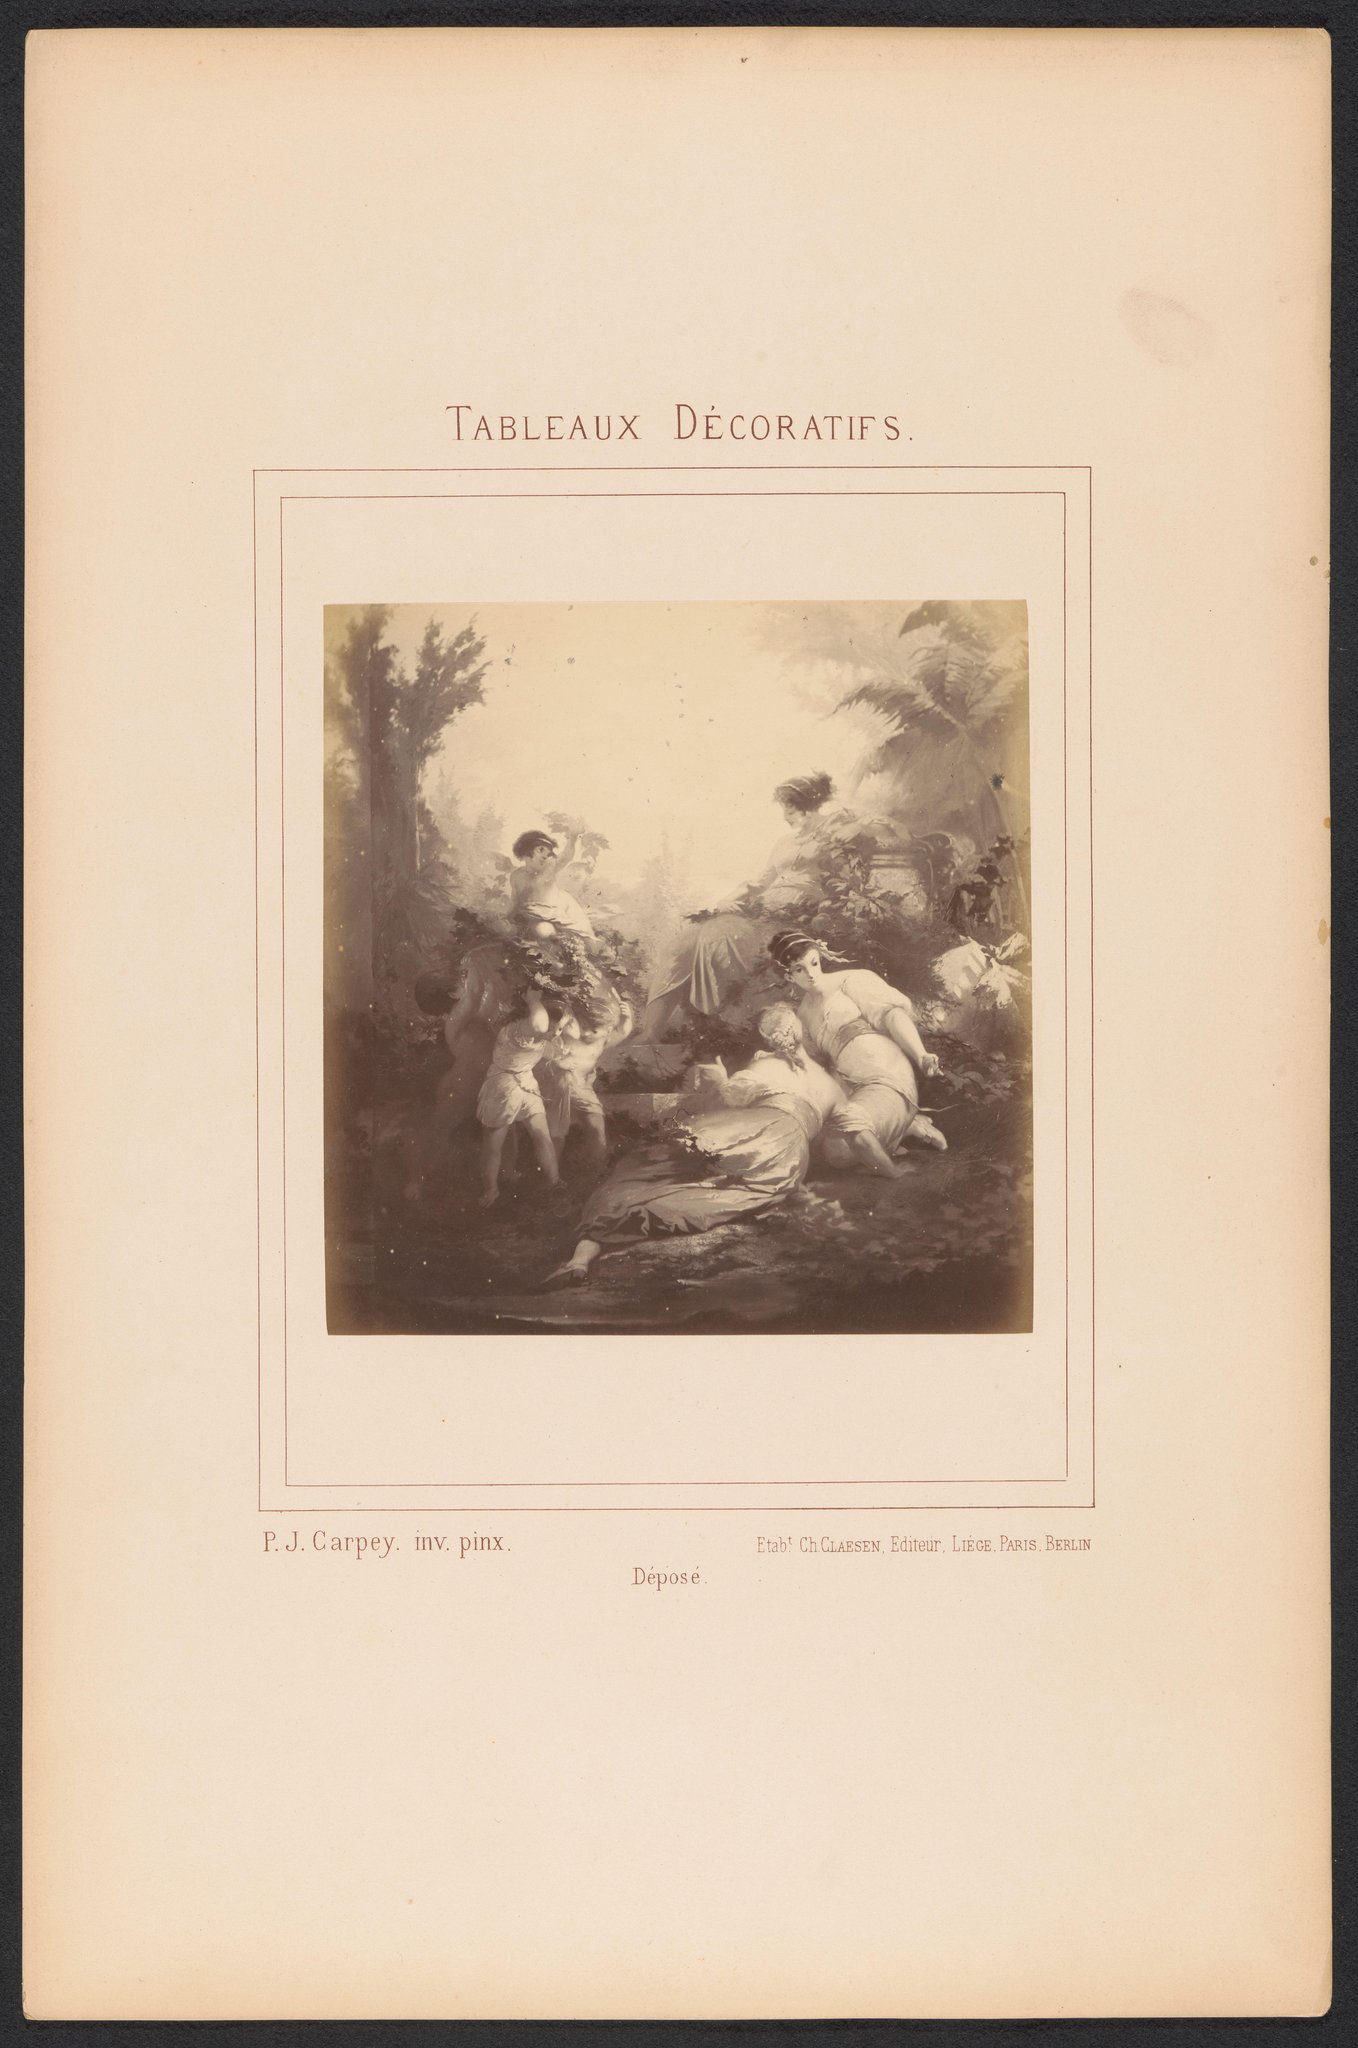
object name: photograph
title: Tableaux Décoratifs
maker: paul-joseph carpay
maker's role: painter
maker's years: 1822-1892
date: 1874-1881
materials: photographic support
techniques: albumen print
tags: adult woman, child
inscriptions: inscription: ‘Etabt. Ch.Claesen, Editeur, Liége, Paris, Berlin’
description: Deze foto maakt deel uit van een omslag met 24 foto's op 22 bladen.